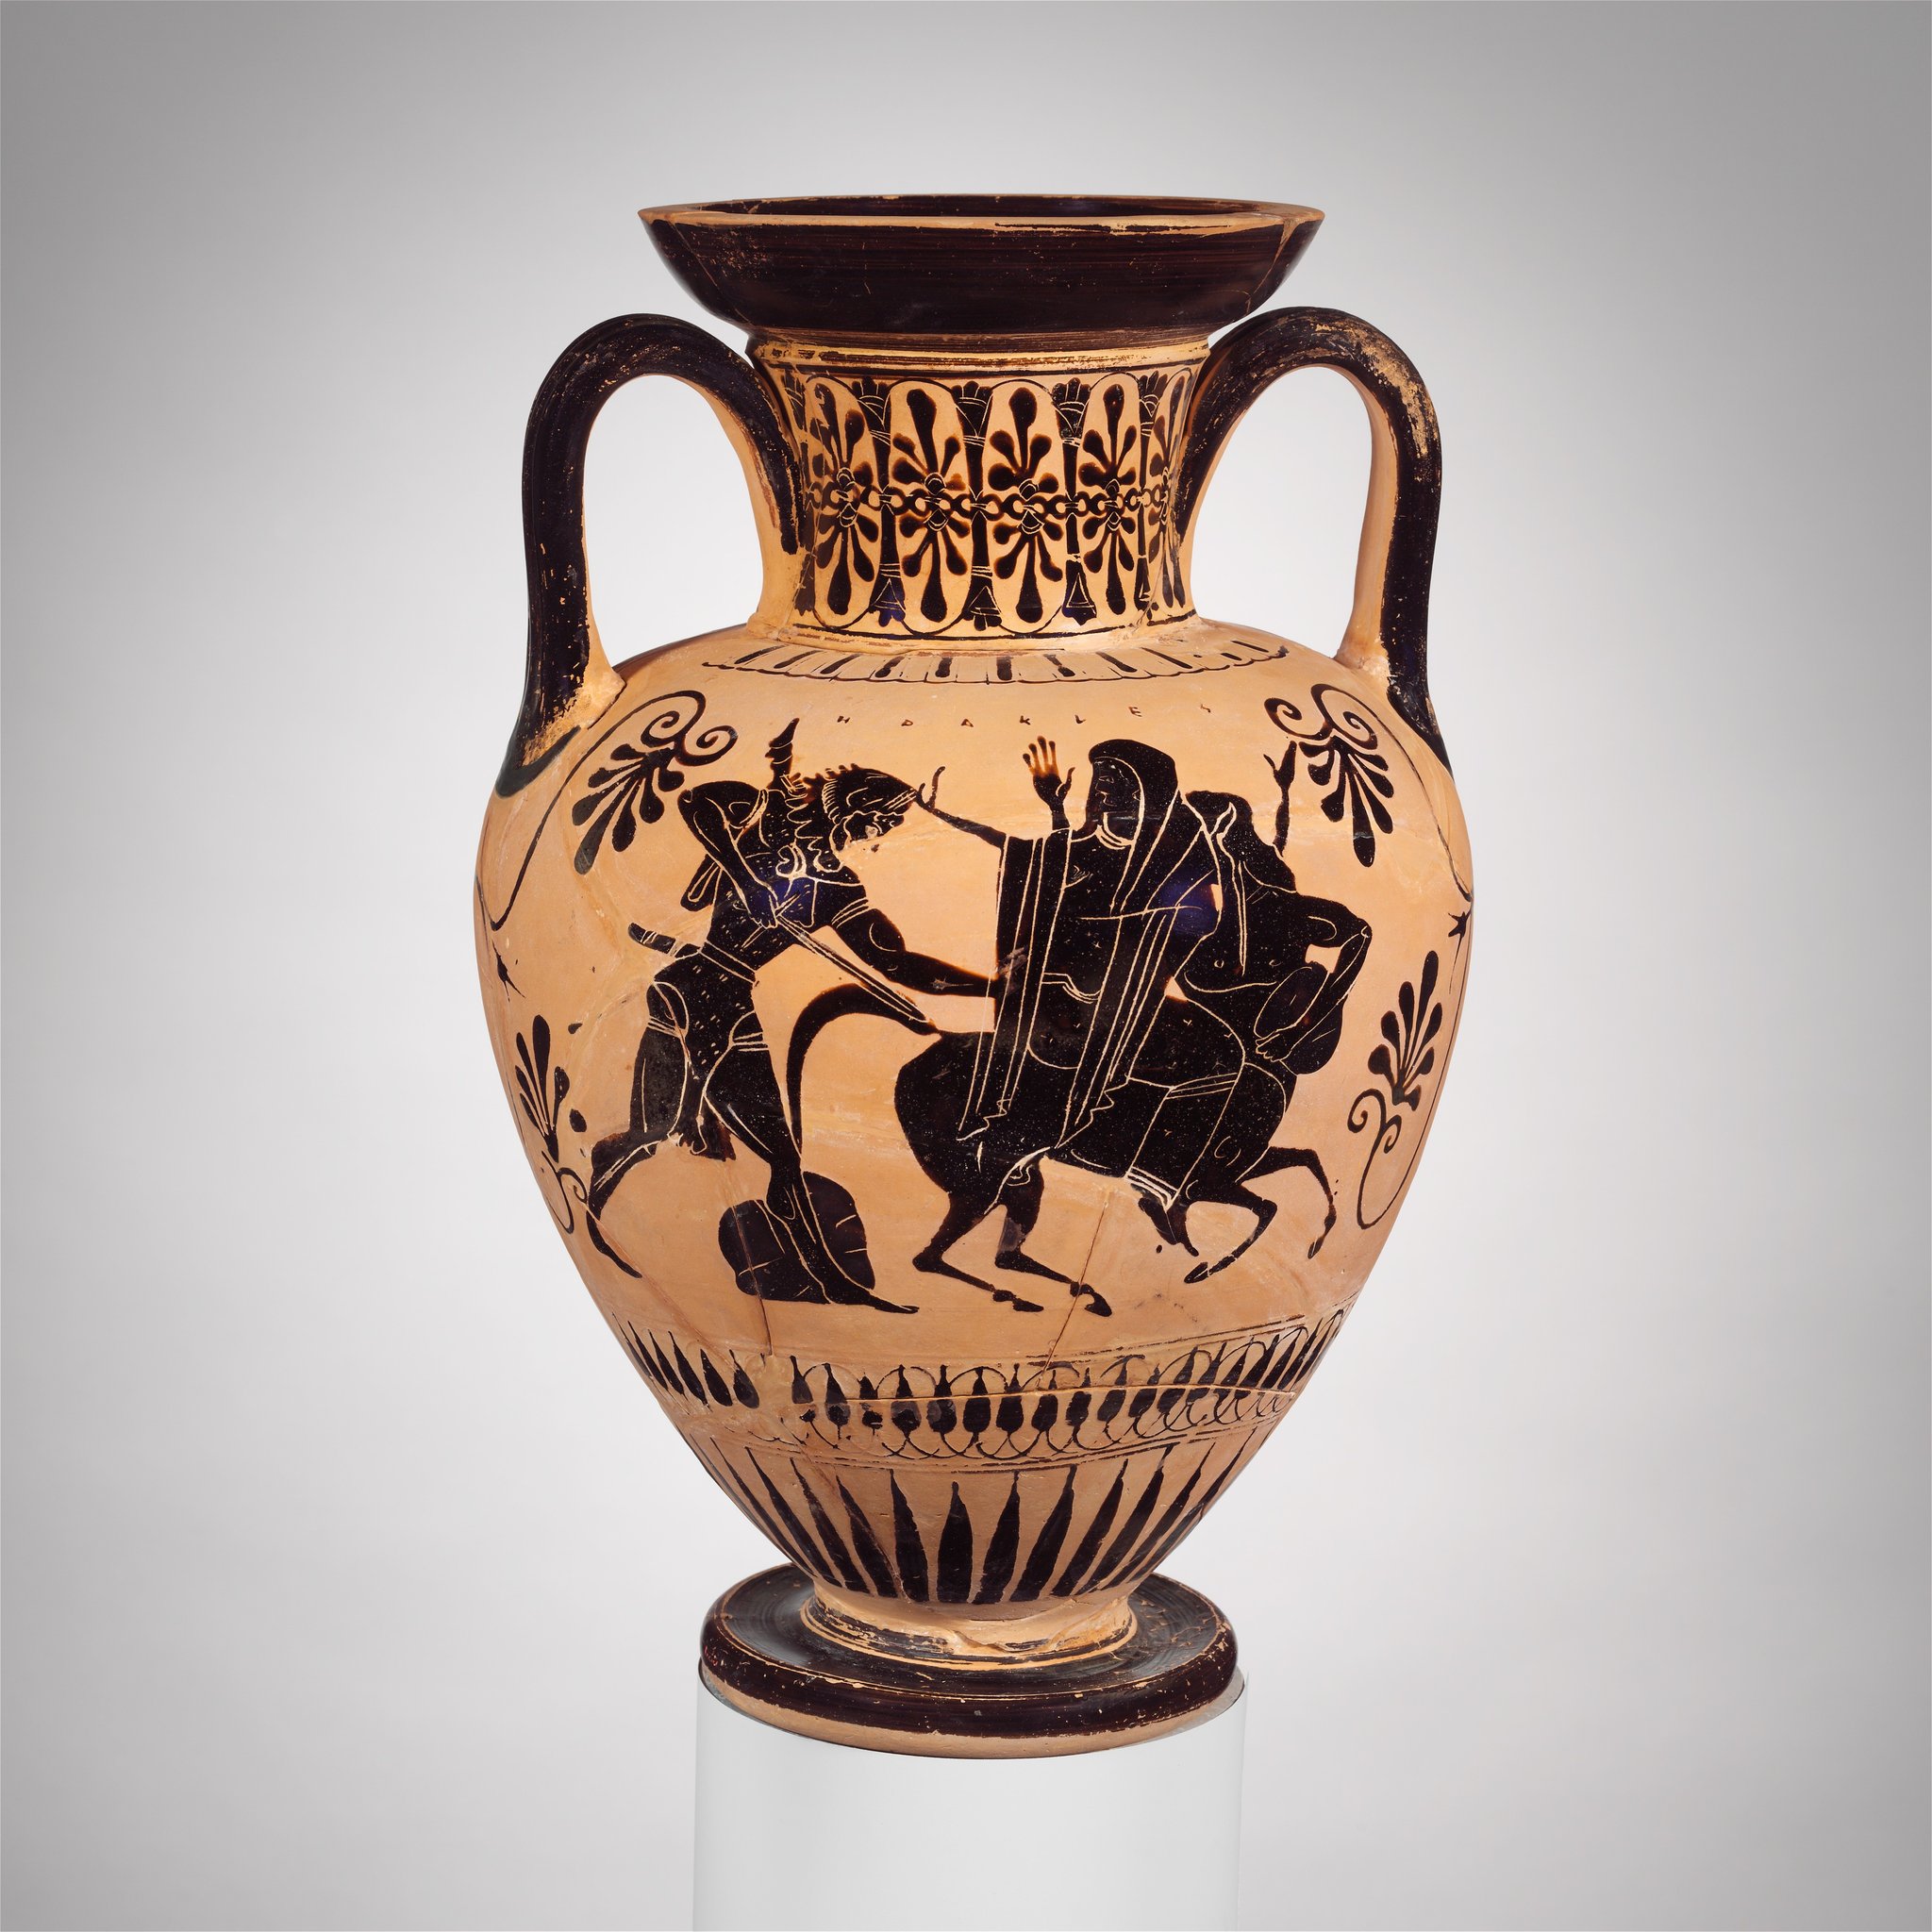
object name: neck amphora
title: Terracotta neck-amphora (jar)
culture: greek, attic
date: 510 BCE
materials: terracotta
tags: centaurs,herakles